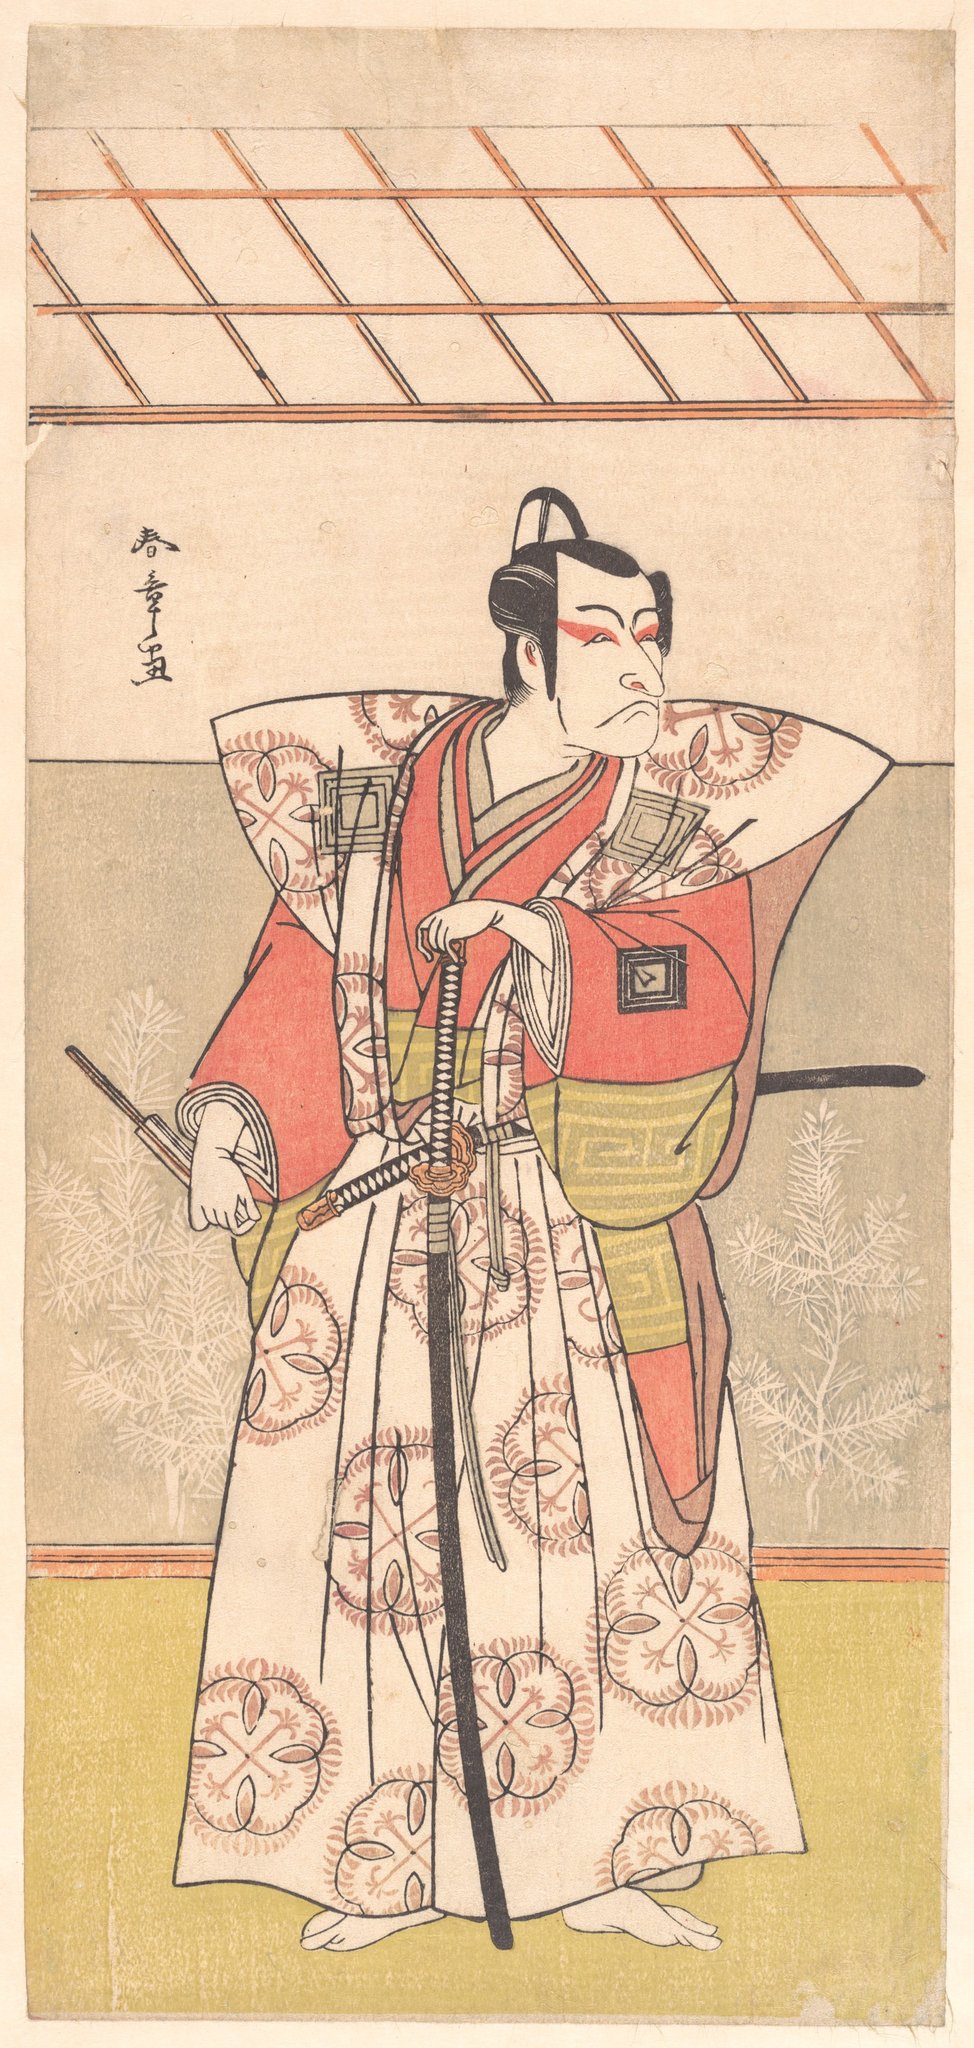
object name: woodblock print nishiki e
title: Ichikawa Danjuro V as a Samurai of High Rank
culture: japanese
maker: katsukawa shunshō 勝川春章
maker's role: artist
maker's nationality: japanese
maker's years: 1726-1792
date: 1778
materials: ink, paper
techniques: nishiki e, woodblock print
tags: swords,men,actors